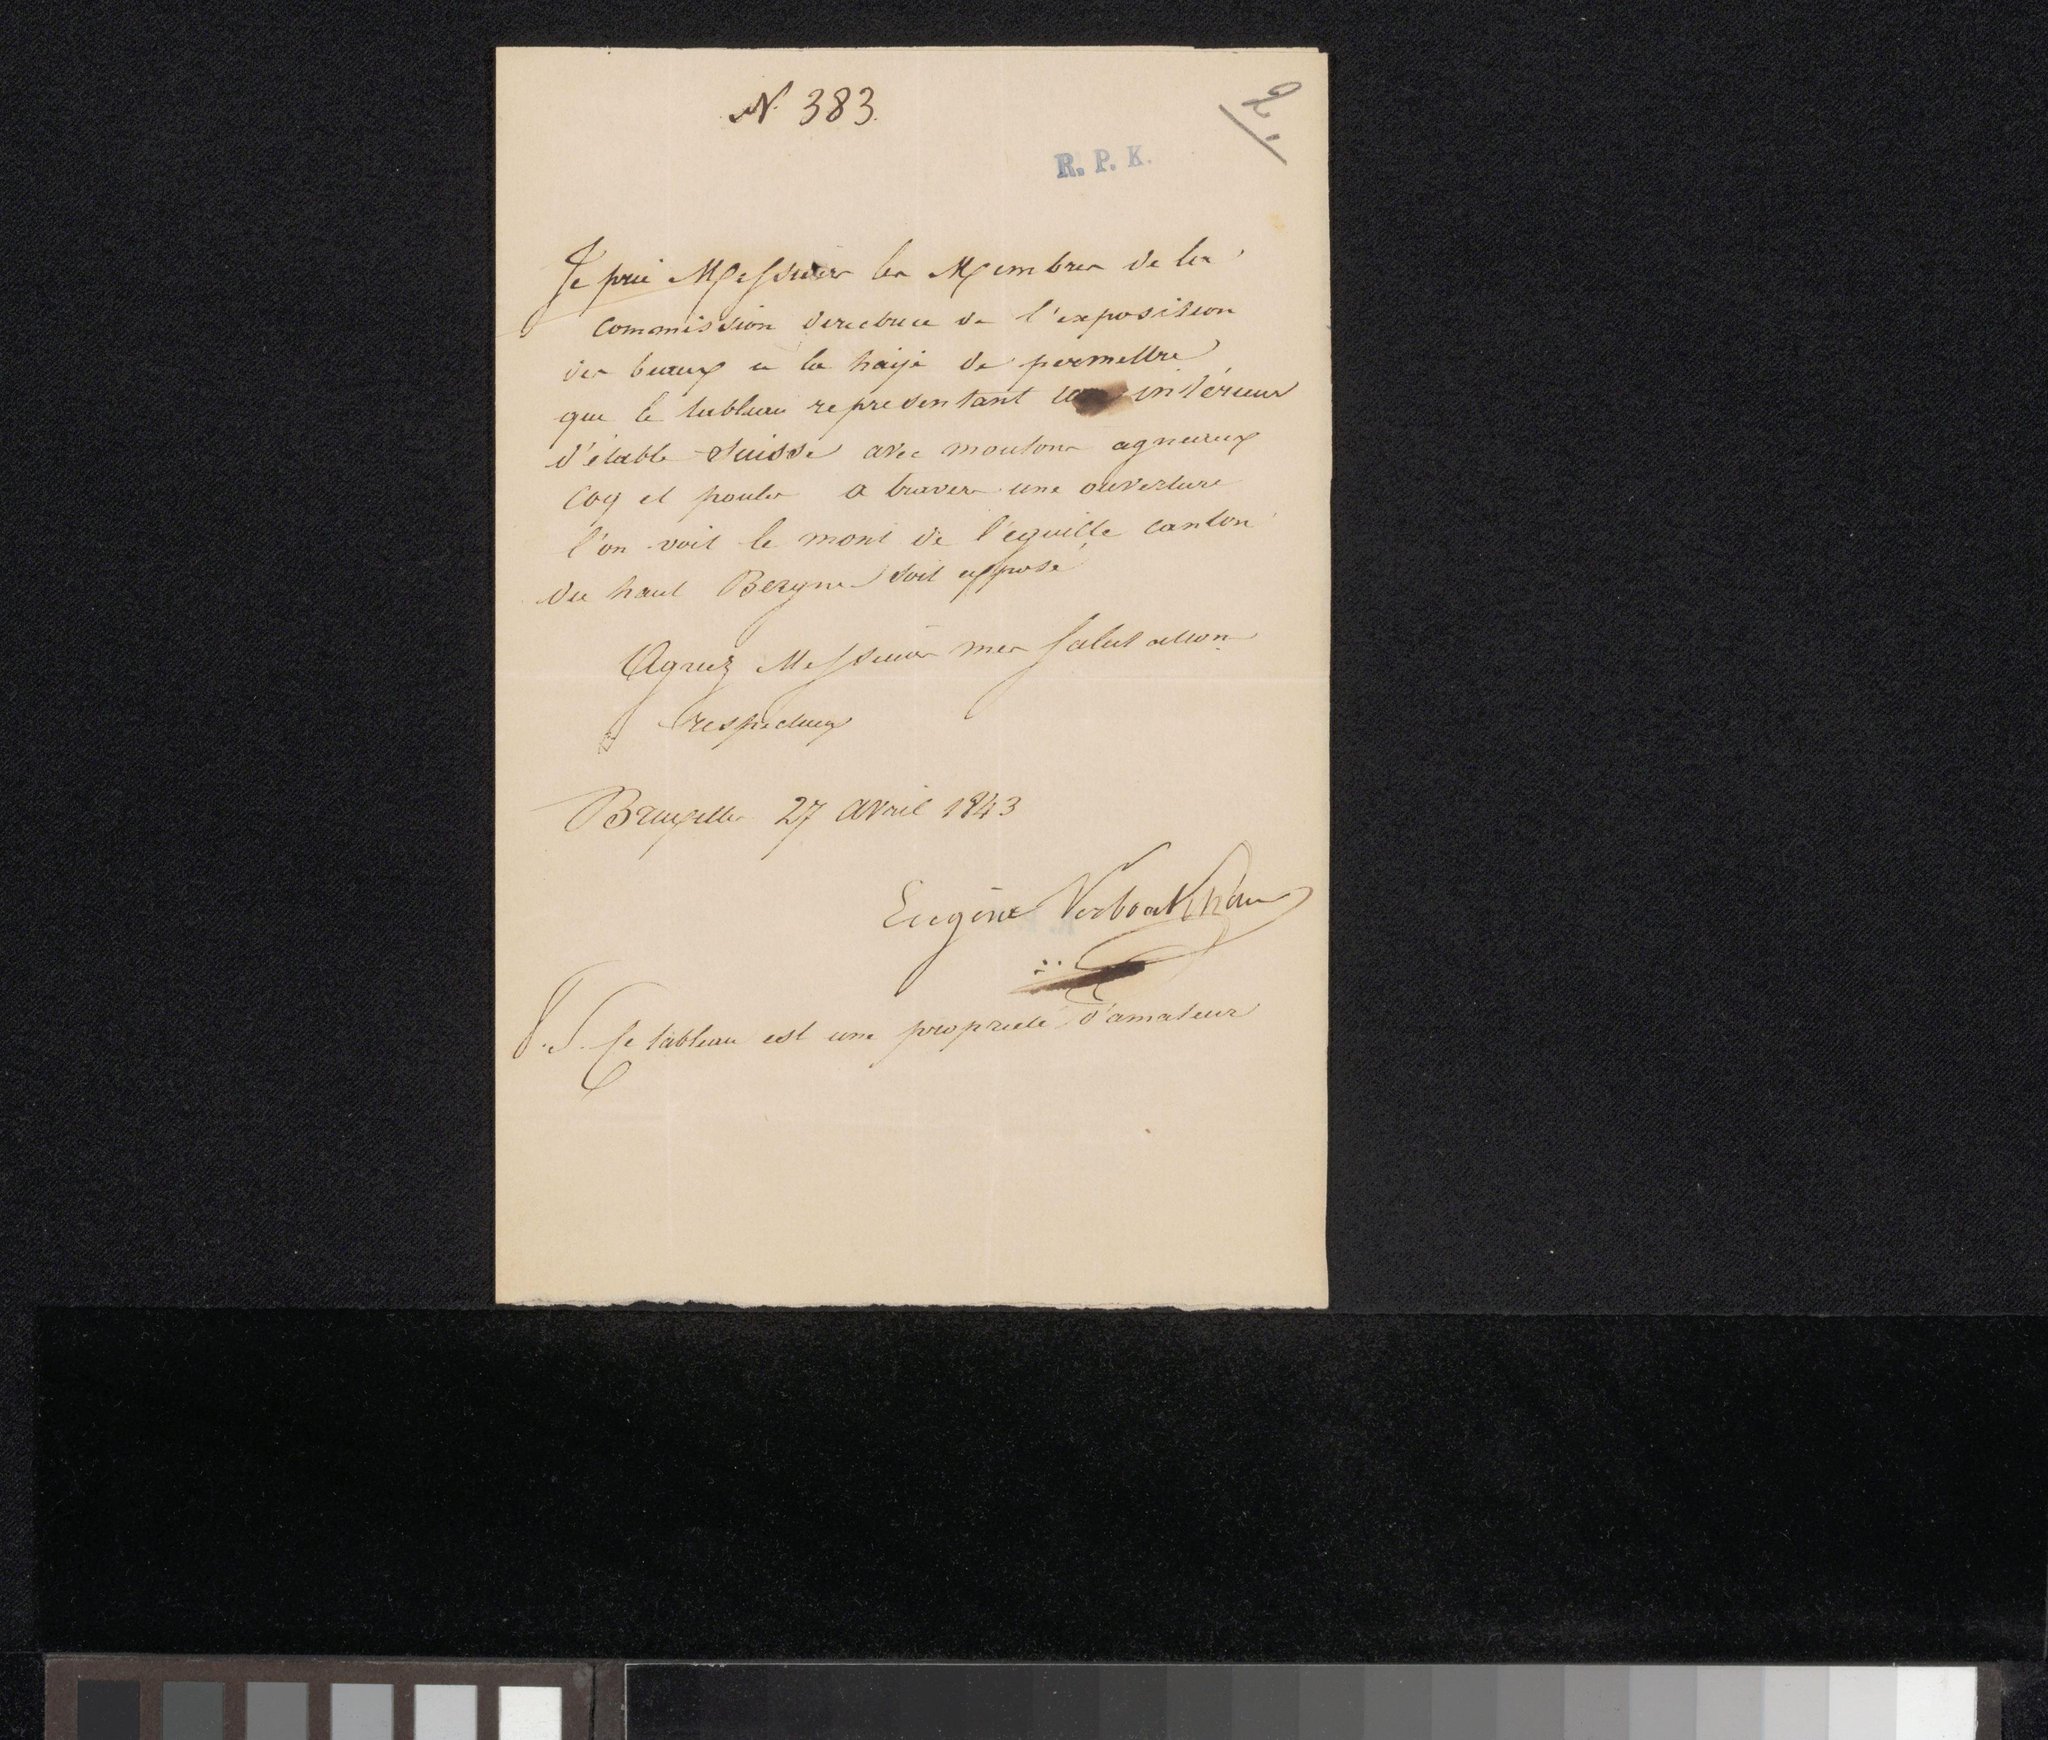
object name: letter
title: Brief aan de commissie van de Tentoonstelling van Levende Meesters in Den Haag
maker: eugène verboeckhoven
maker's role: draughtsman, painter, print maker, printer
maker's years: 1798-1881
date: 1843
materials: ink, paper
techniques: pen, writing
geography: brussels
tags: painting (including book-illumination, miniature-painting), exhibition ~ art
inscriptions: collector's mark: Lugt 2233